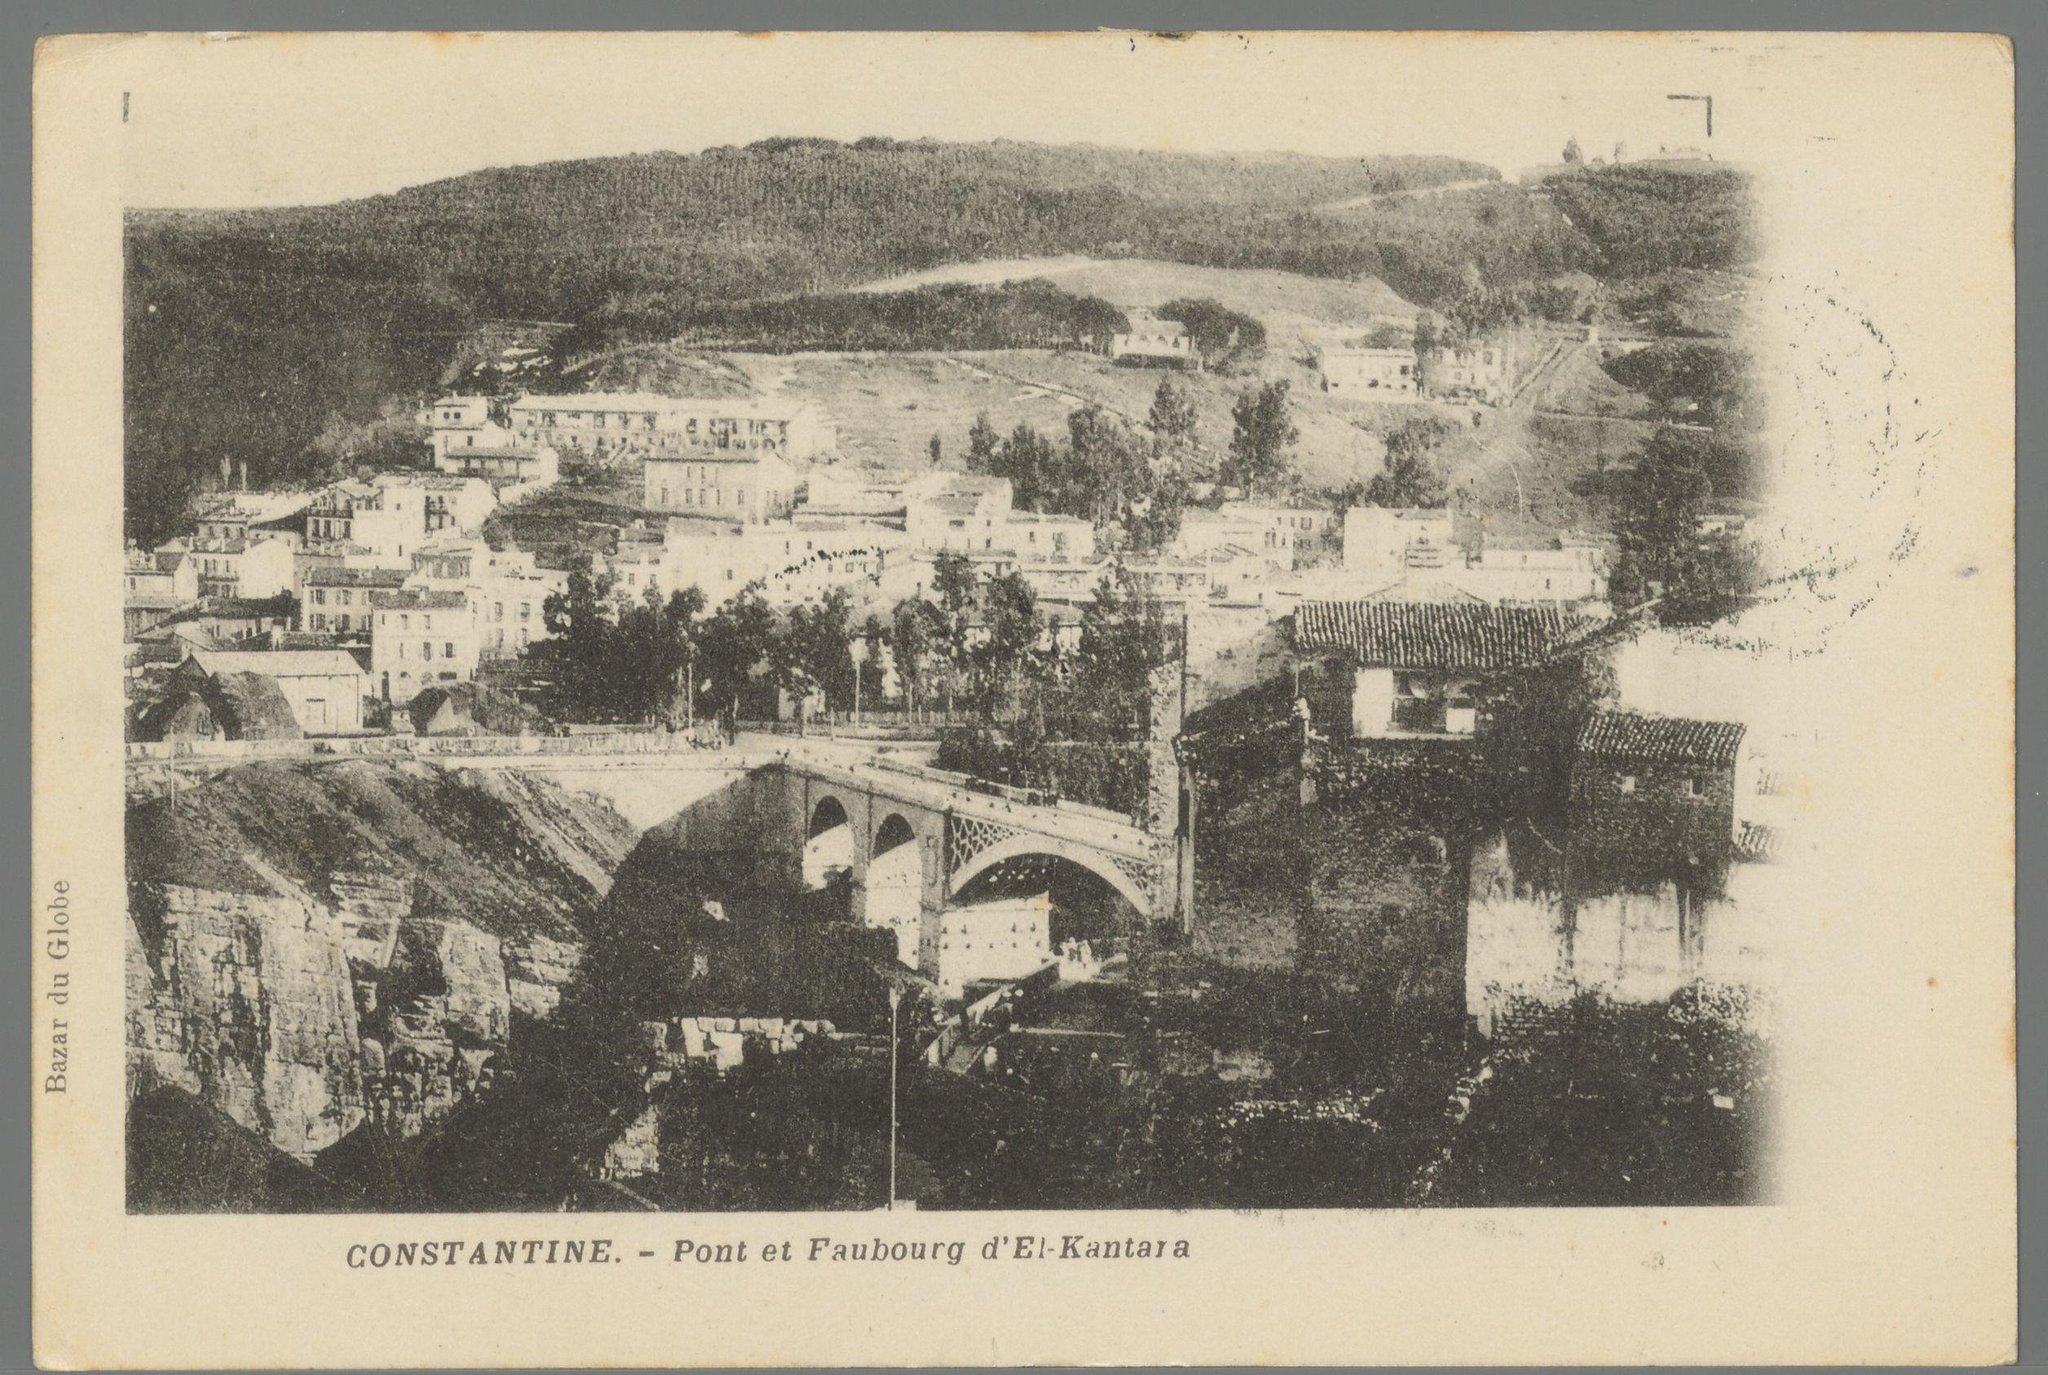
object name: photomechanical print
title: Constantine. Pont et Faubourg d'El-Kantara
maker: Anonymous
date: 1890-1903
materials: cardboard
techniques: photograph, writing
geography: constantine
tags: bridge, prospect of city, town panorama, silhouette of city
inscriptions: postage stamp